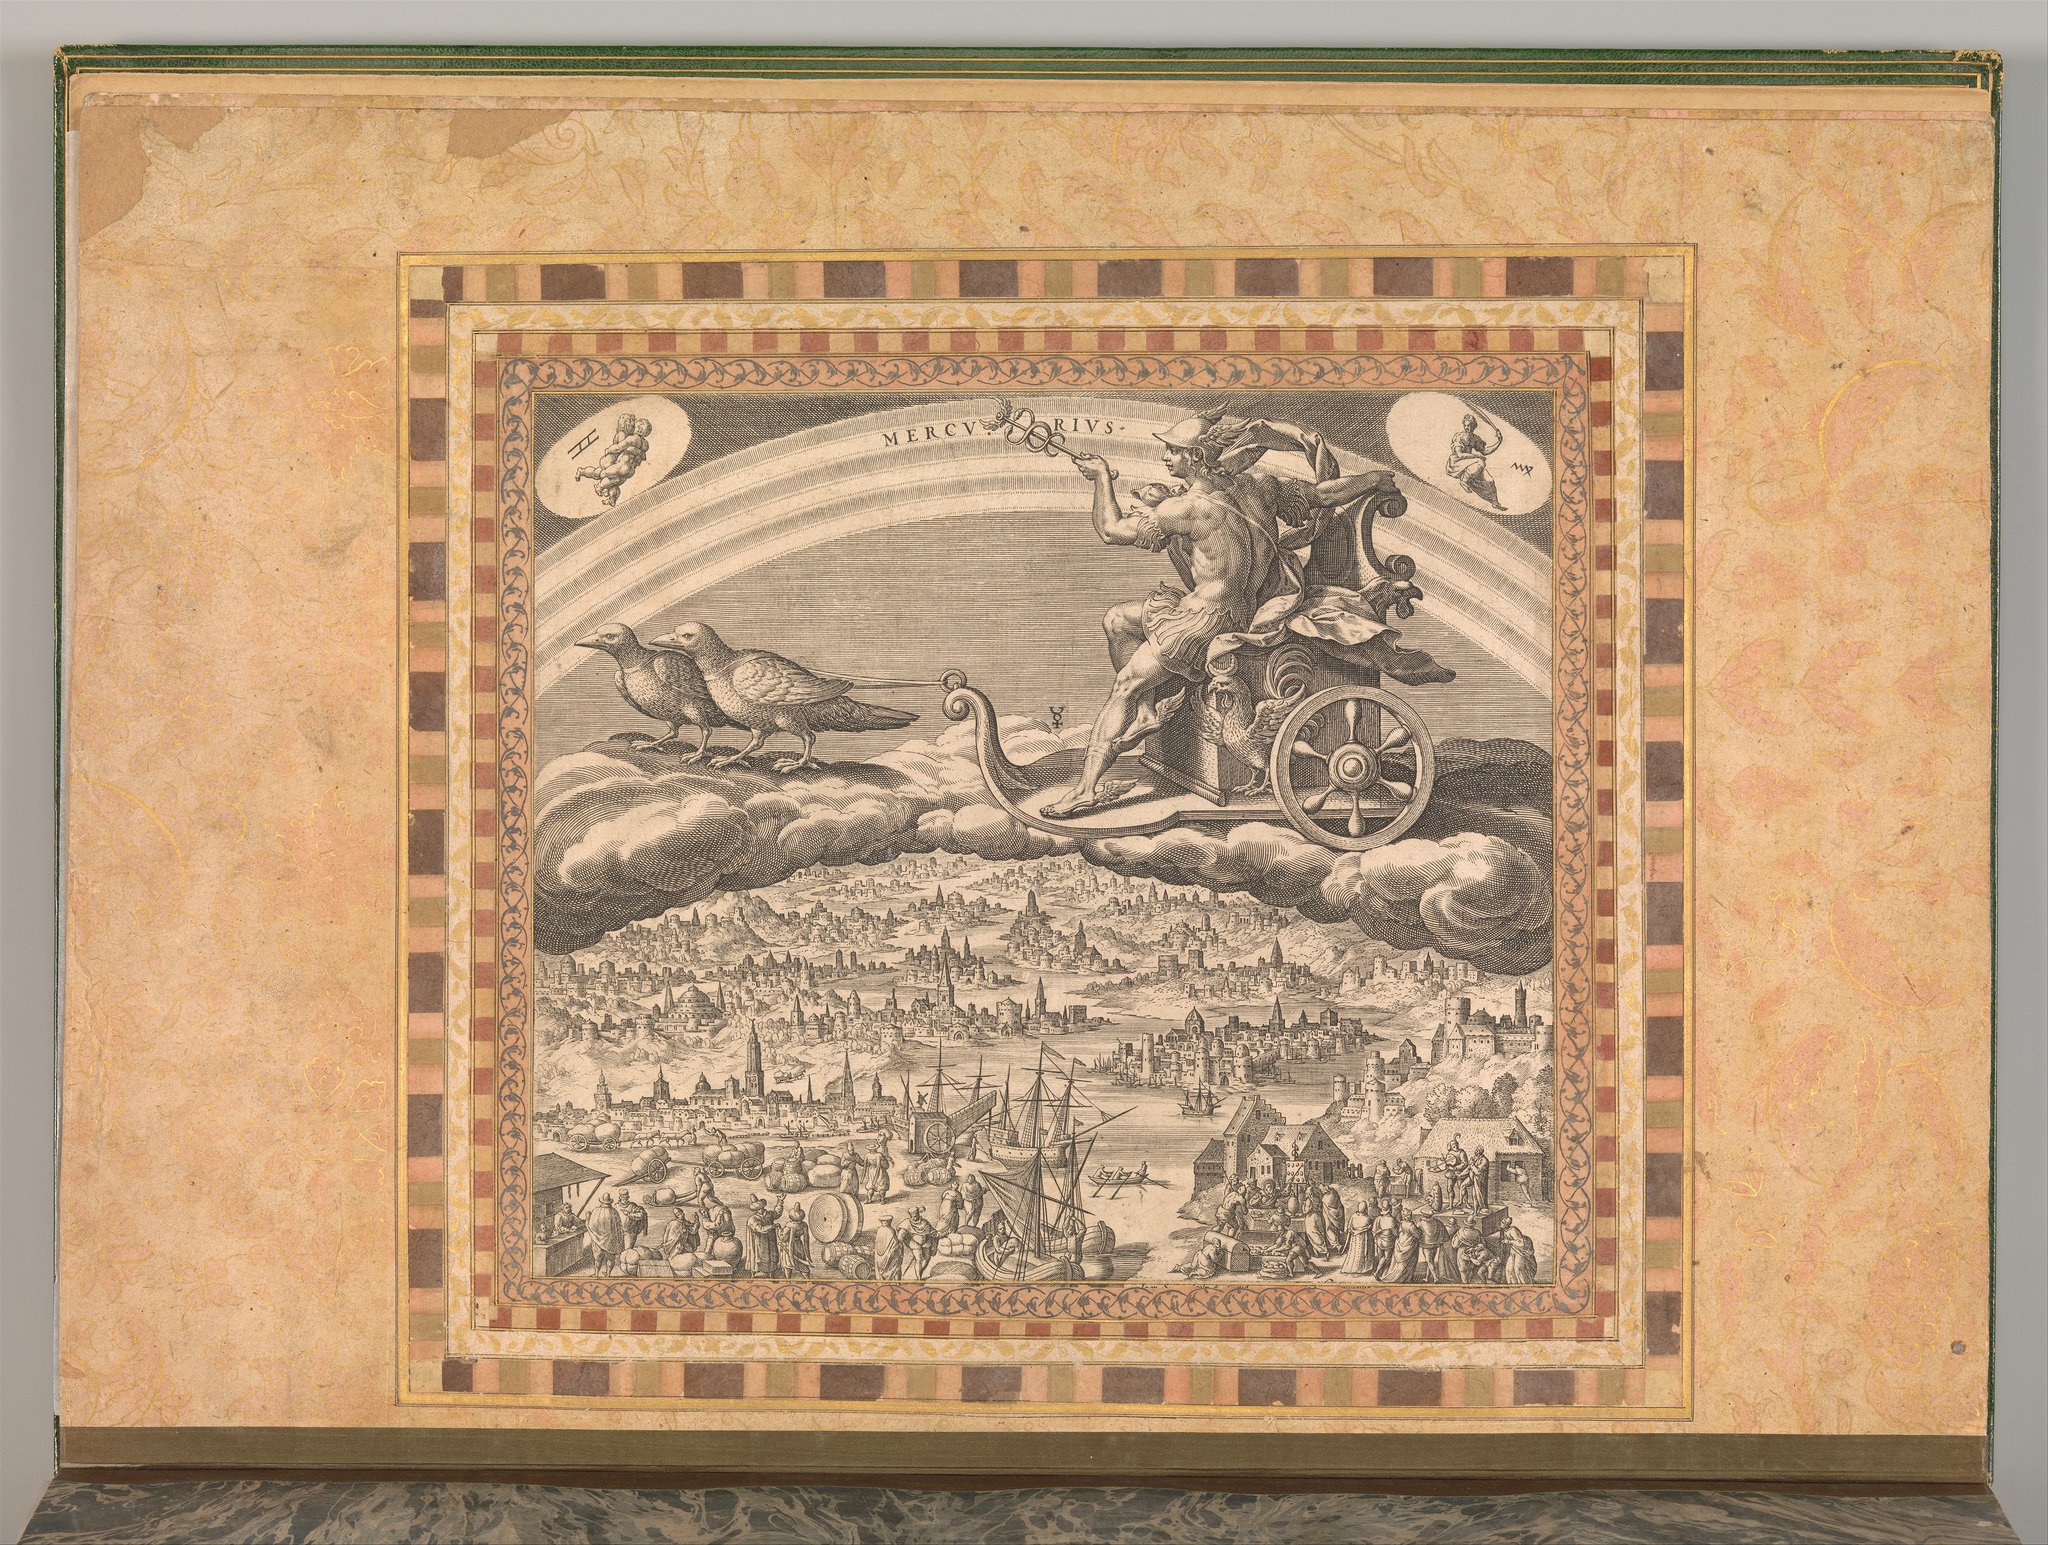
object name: illustrated album leaf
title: "Mercury," Folio from the Bellini Album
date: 1600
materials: gold, ink, paper, watercolor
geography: netherlands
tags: birds,mercury,chariots